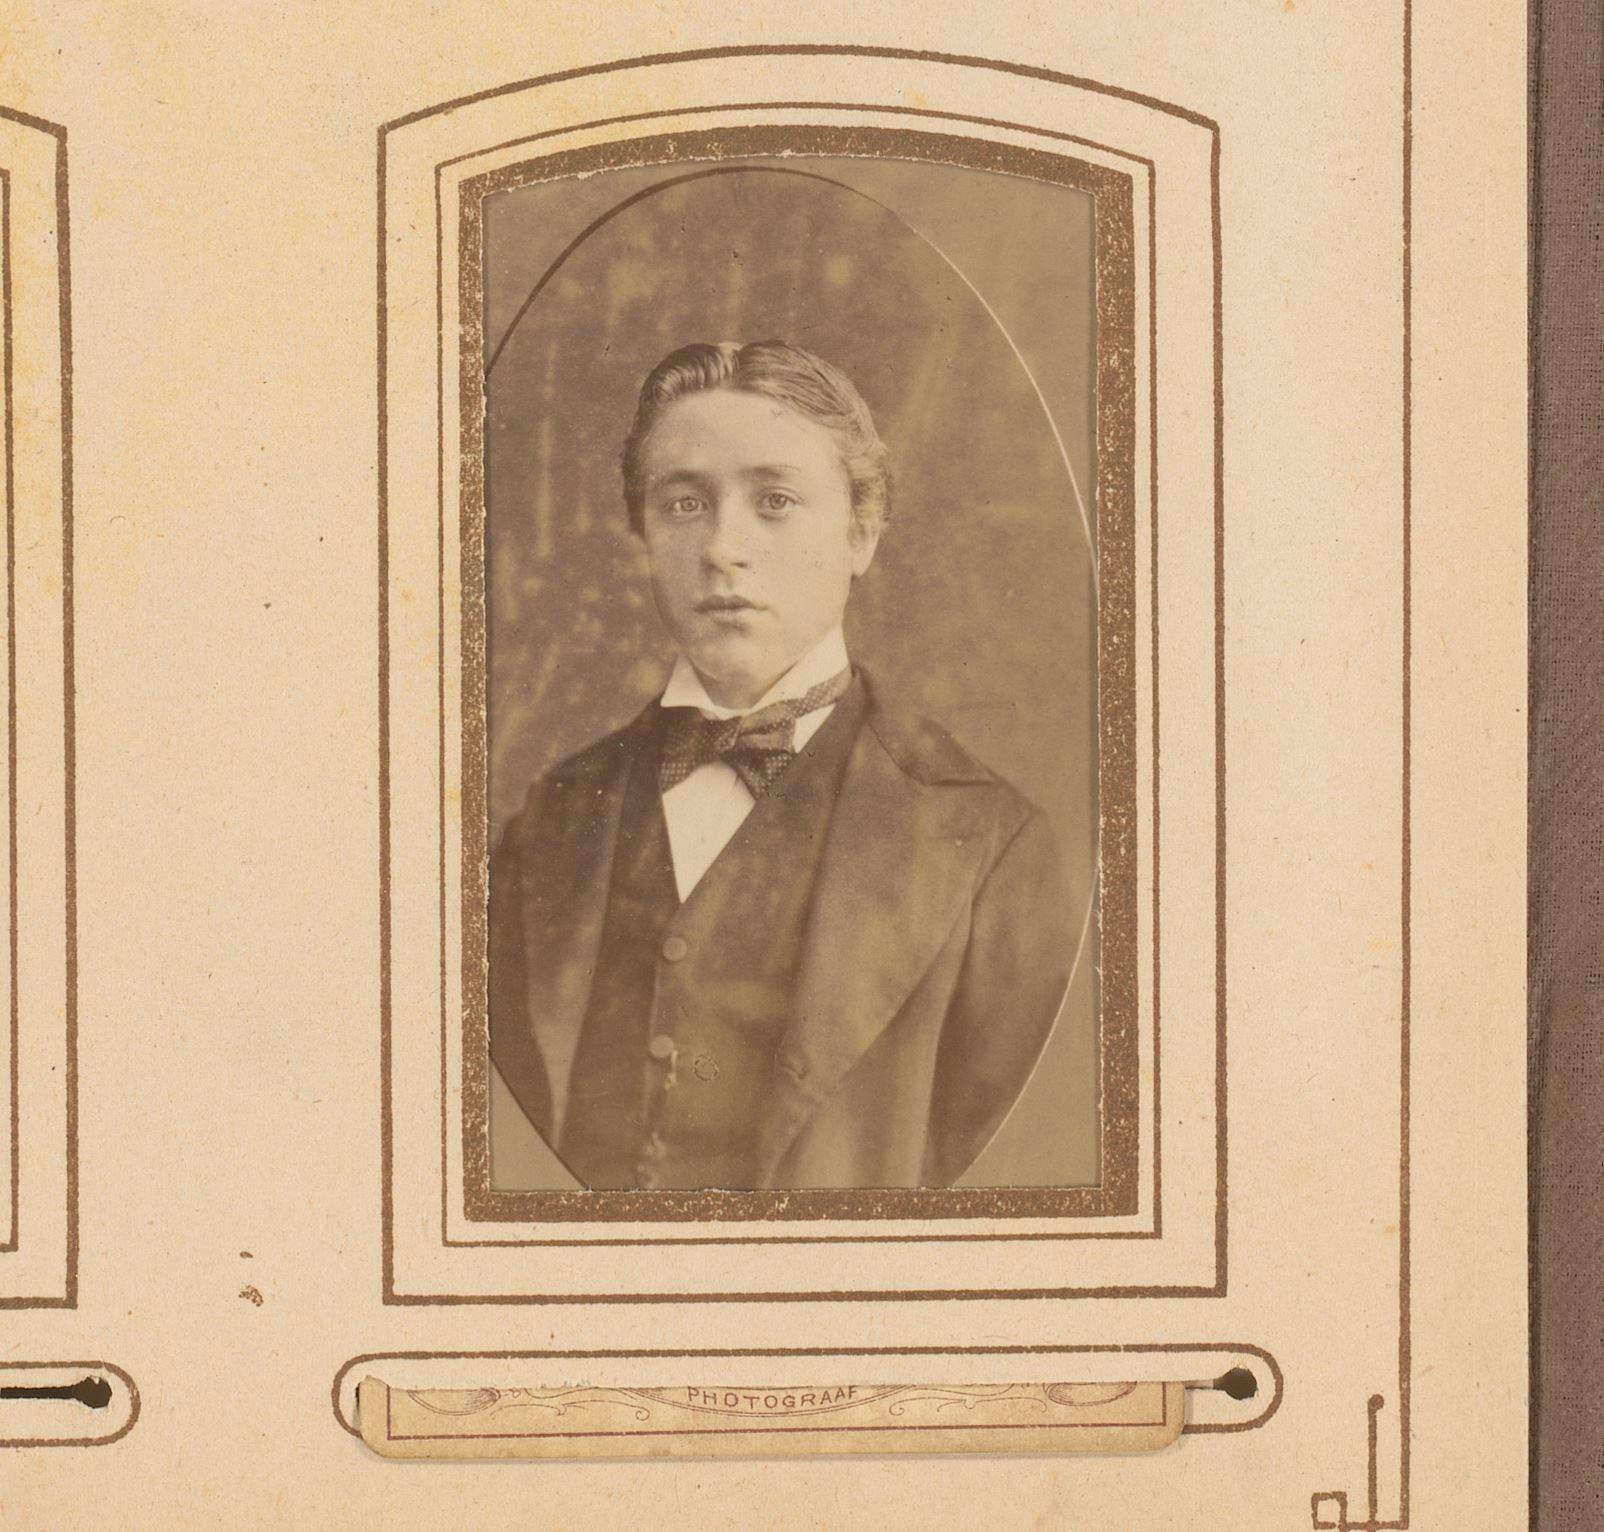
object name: album leaf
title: Portret van een jongeman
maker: august ferdinand heinrich harms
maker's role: fotograaf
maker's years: 1845-1916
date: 1860-1890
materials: cardboard, photographic support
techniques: albumen print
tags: historical persons, youth, adolescent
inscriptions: inscription: ‘H. Harms/ Photograaf/ Haverzaklaan/ Leiden (...)’